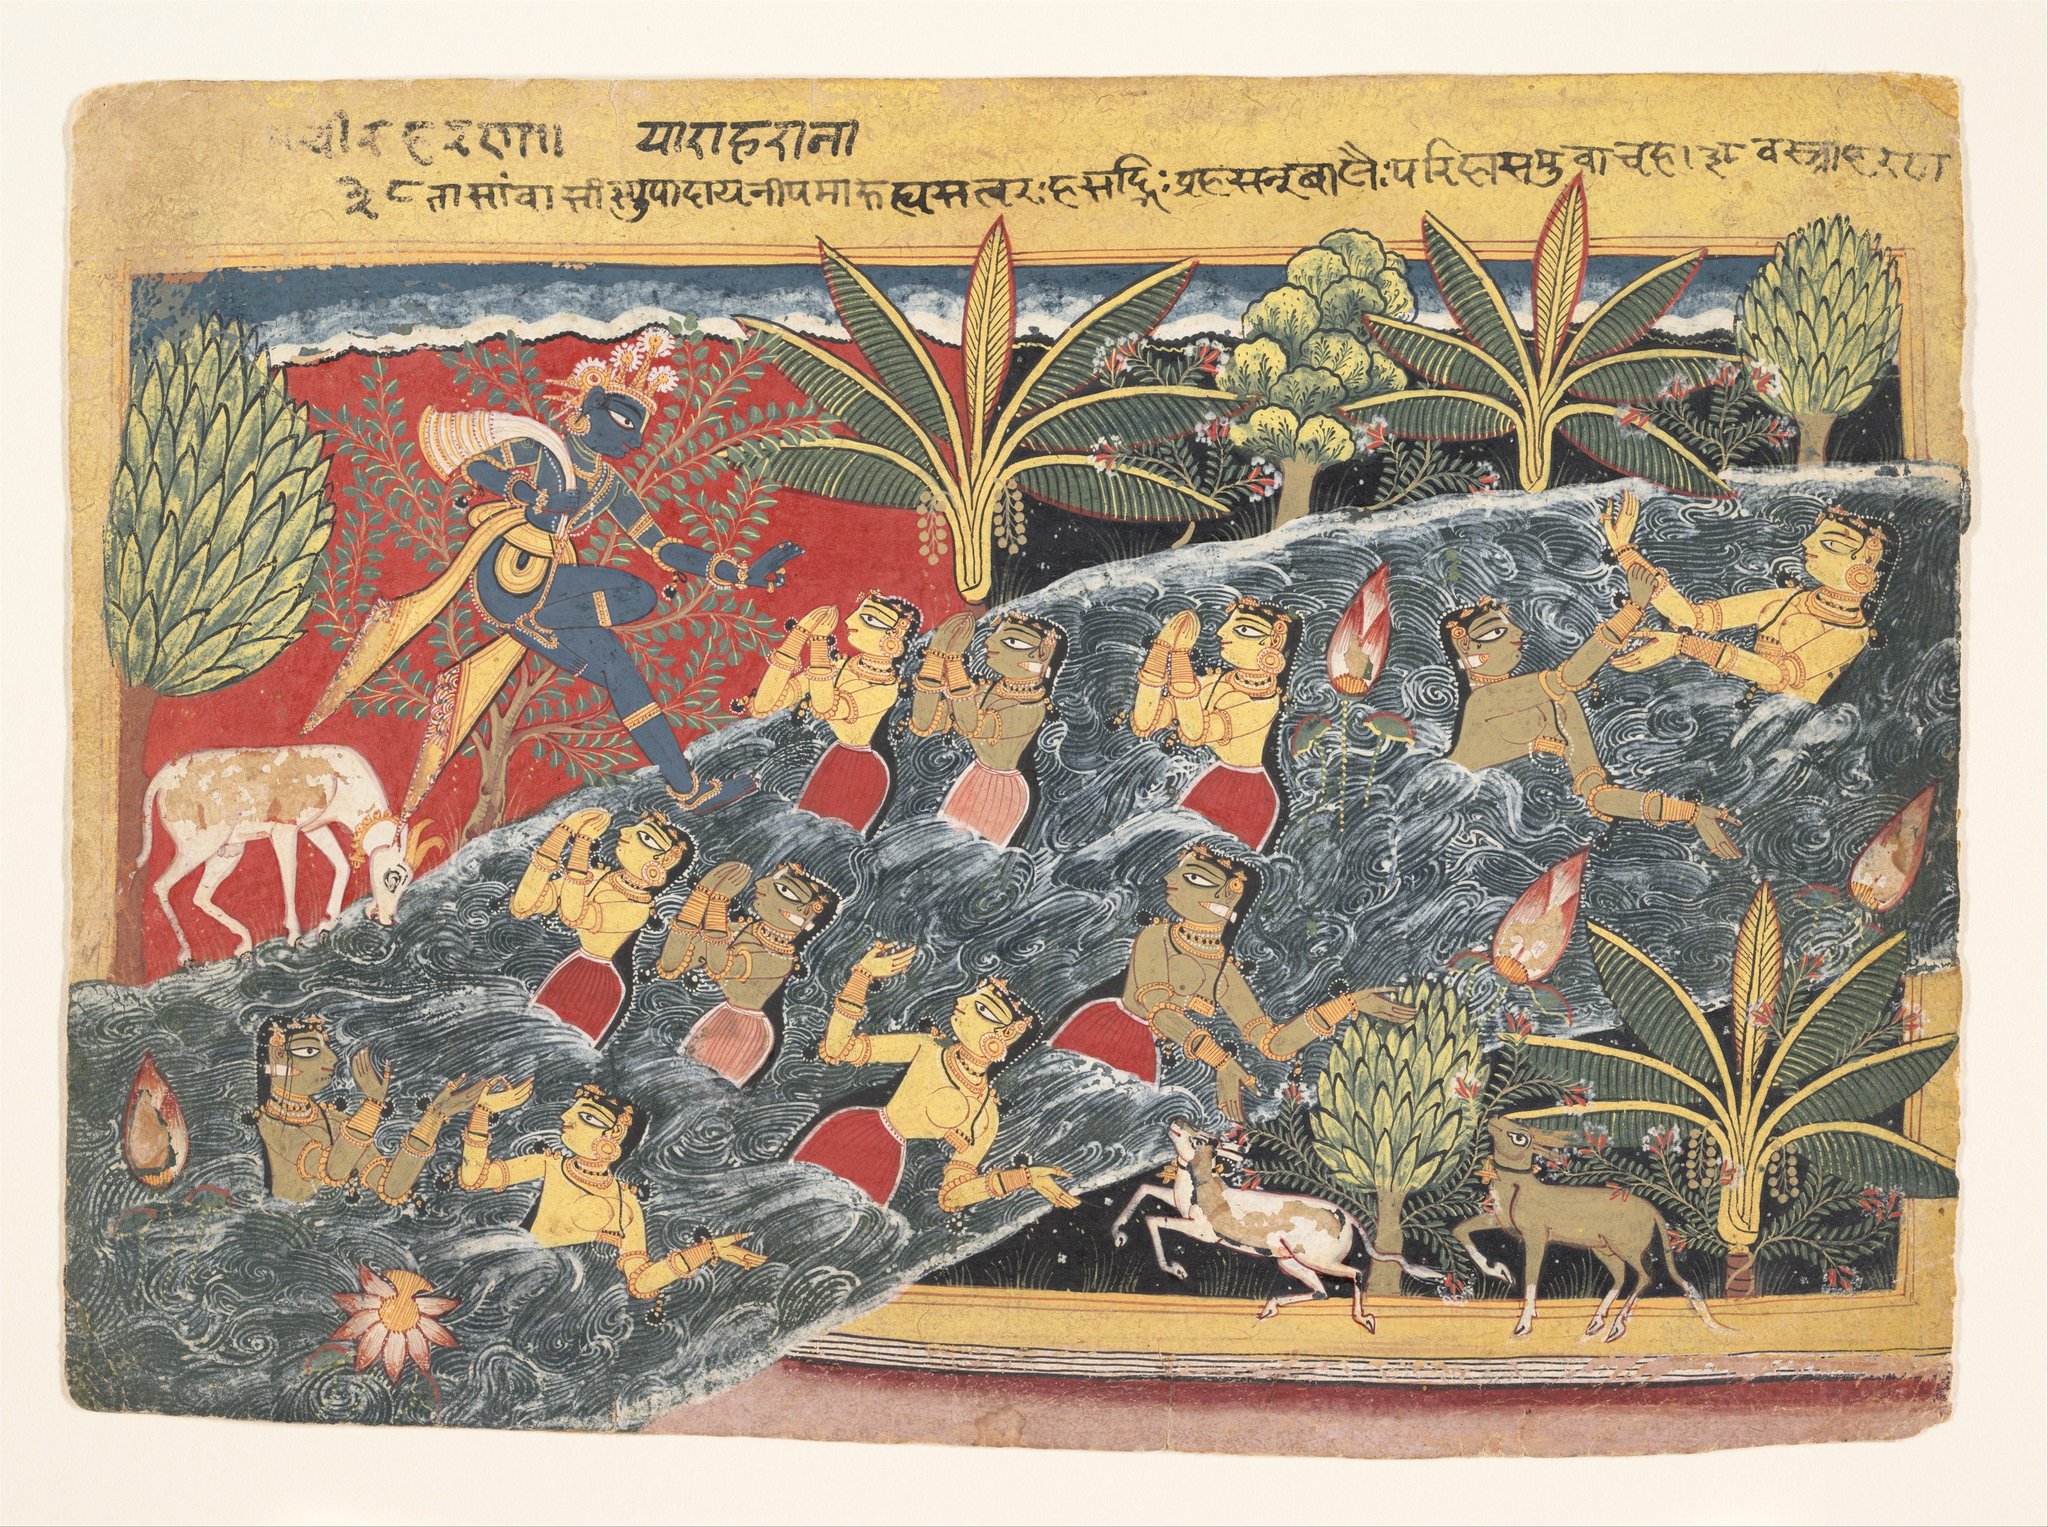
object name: folio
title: The Gopis Plead with Krishna to Return Their Clothing: Folio from "Isarda" Bhagavata Purana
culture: indian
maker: master of the "isarda" bhagavata purana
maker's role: artist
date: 1560-1565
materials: ink, paper, watercolor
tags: women,deer,rivers,krishna